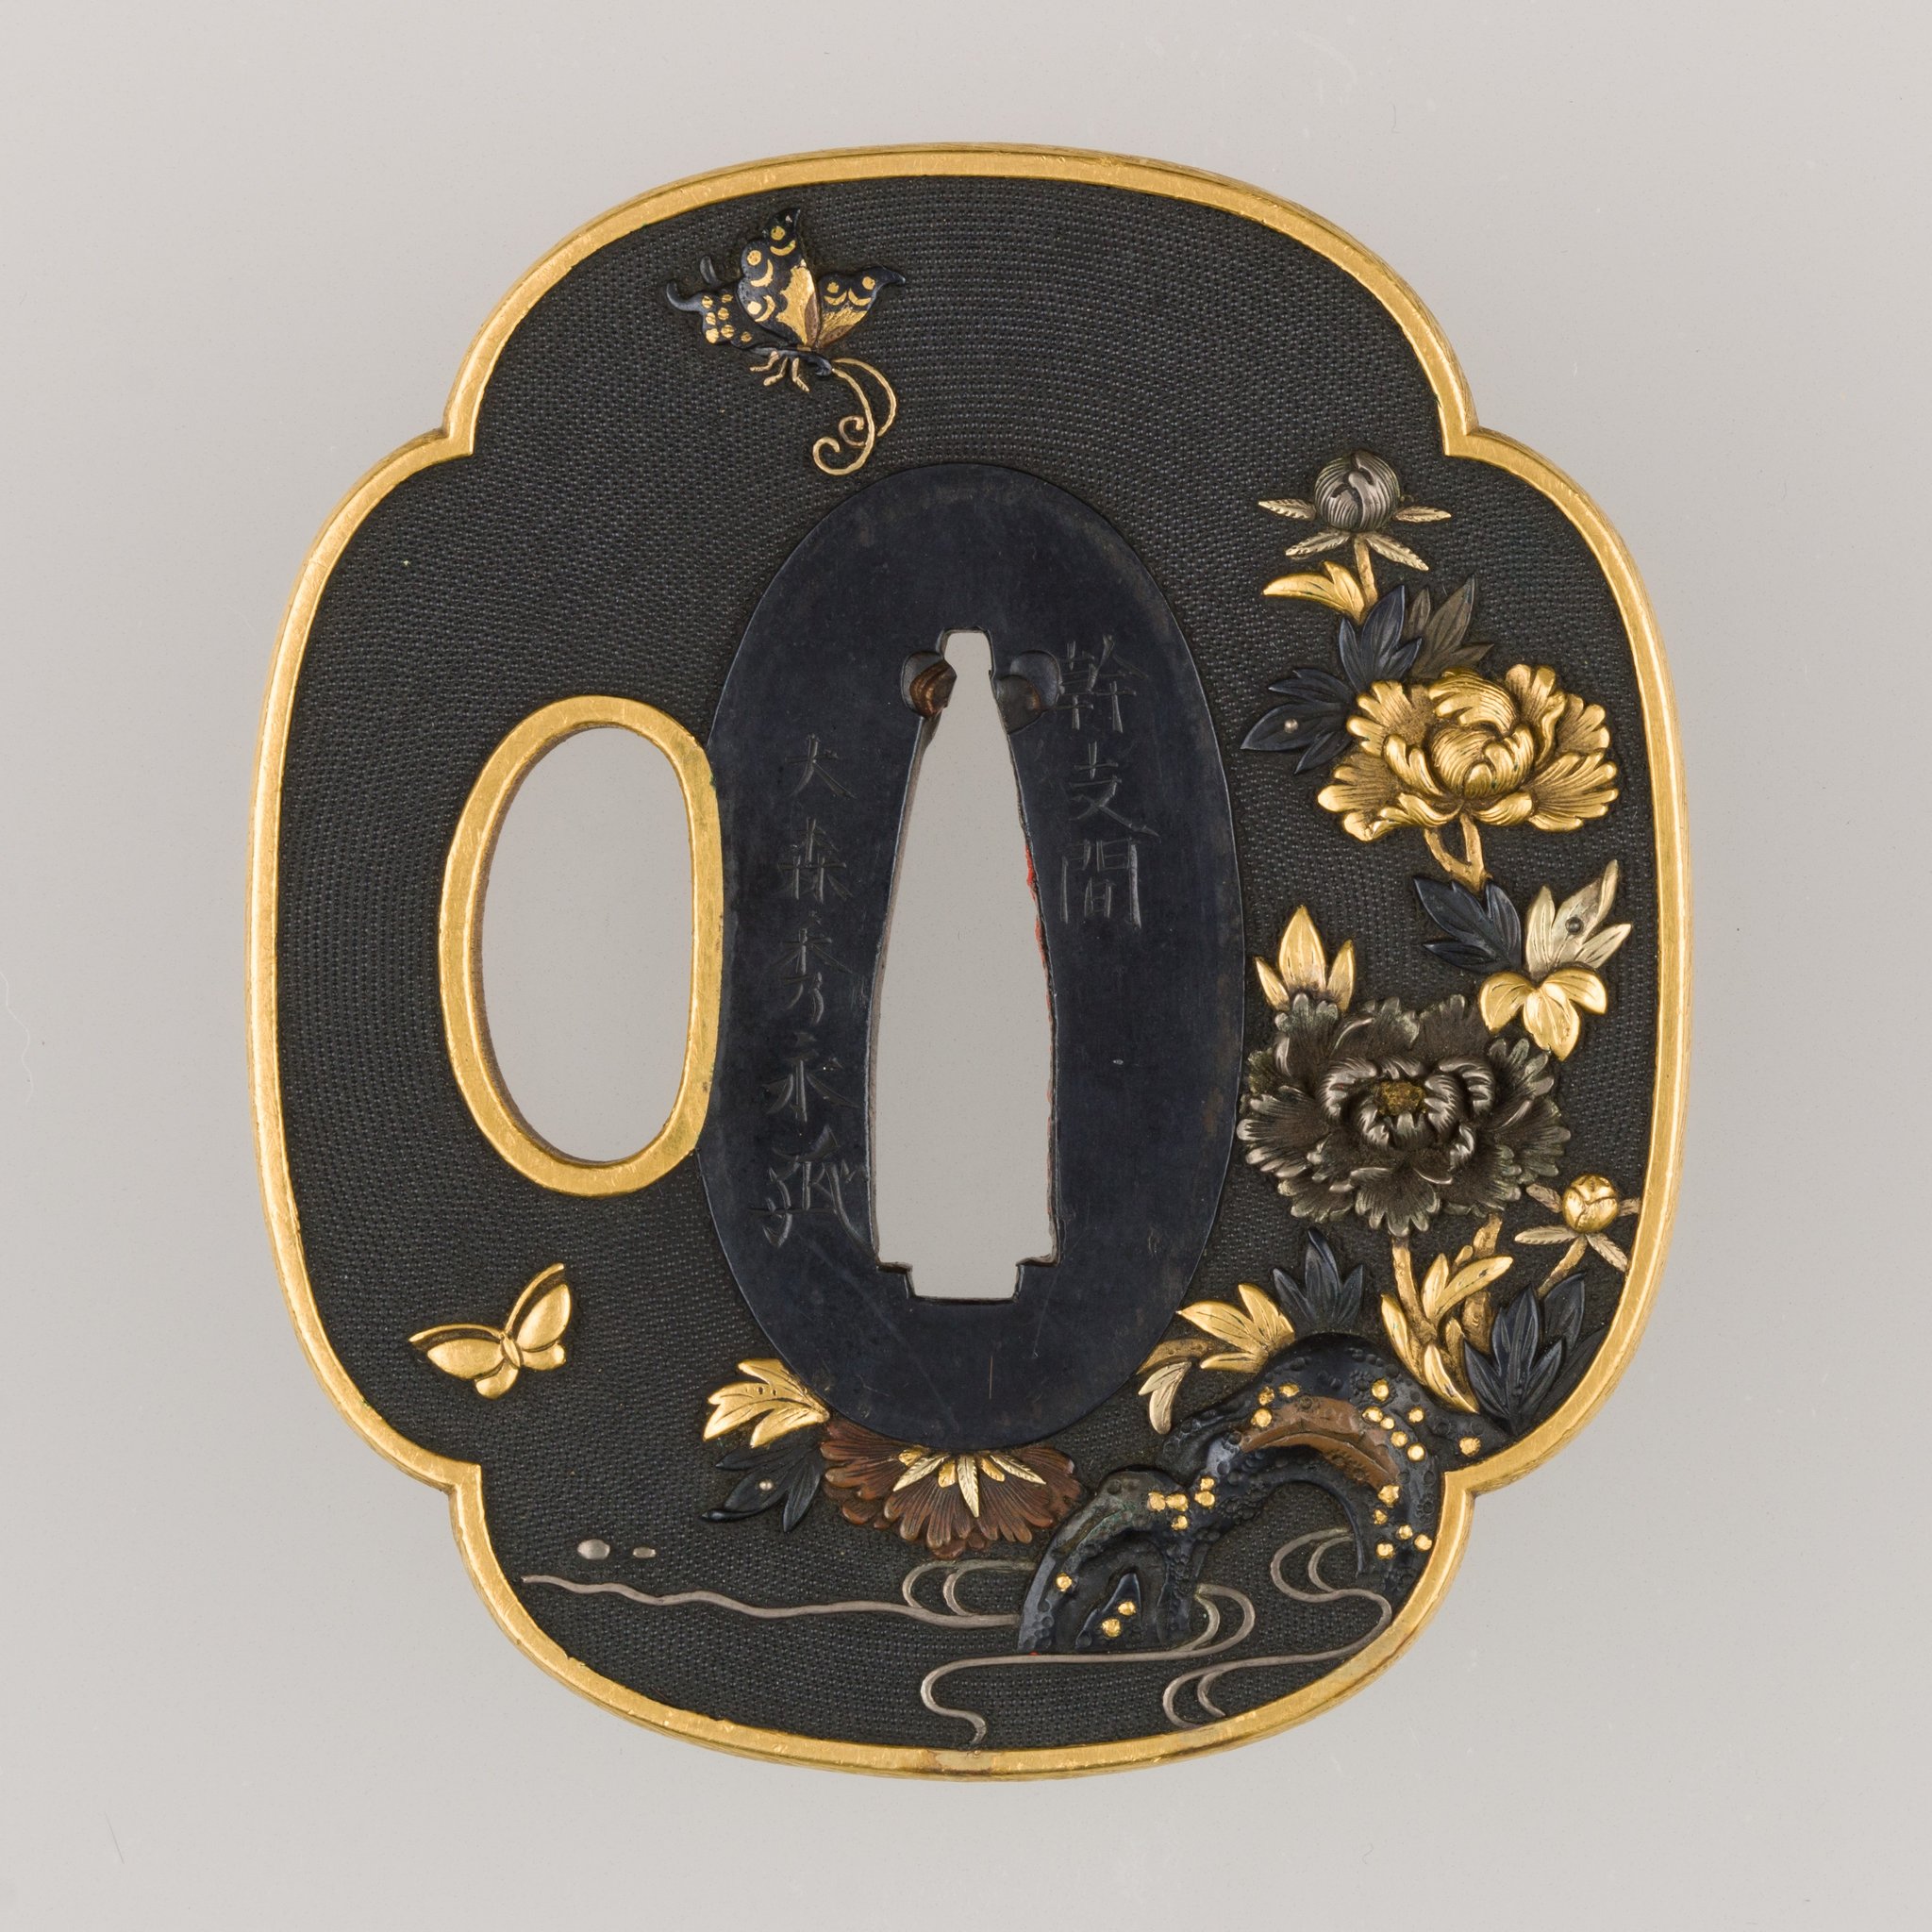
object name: sword guard tsuba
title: Sword Guard (Tsuba)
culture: japanese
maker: omori hidenaga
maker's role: maker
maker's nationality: japanese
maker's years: 1751-1800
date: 1701-1800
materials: copper, gold alloy, gold, silver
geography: japan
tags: butterflies,flowers